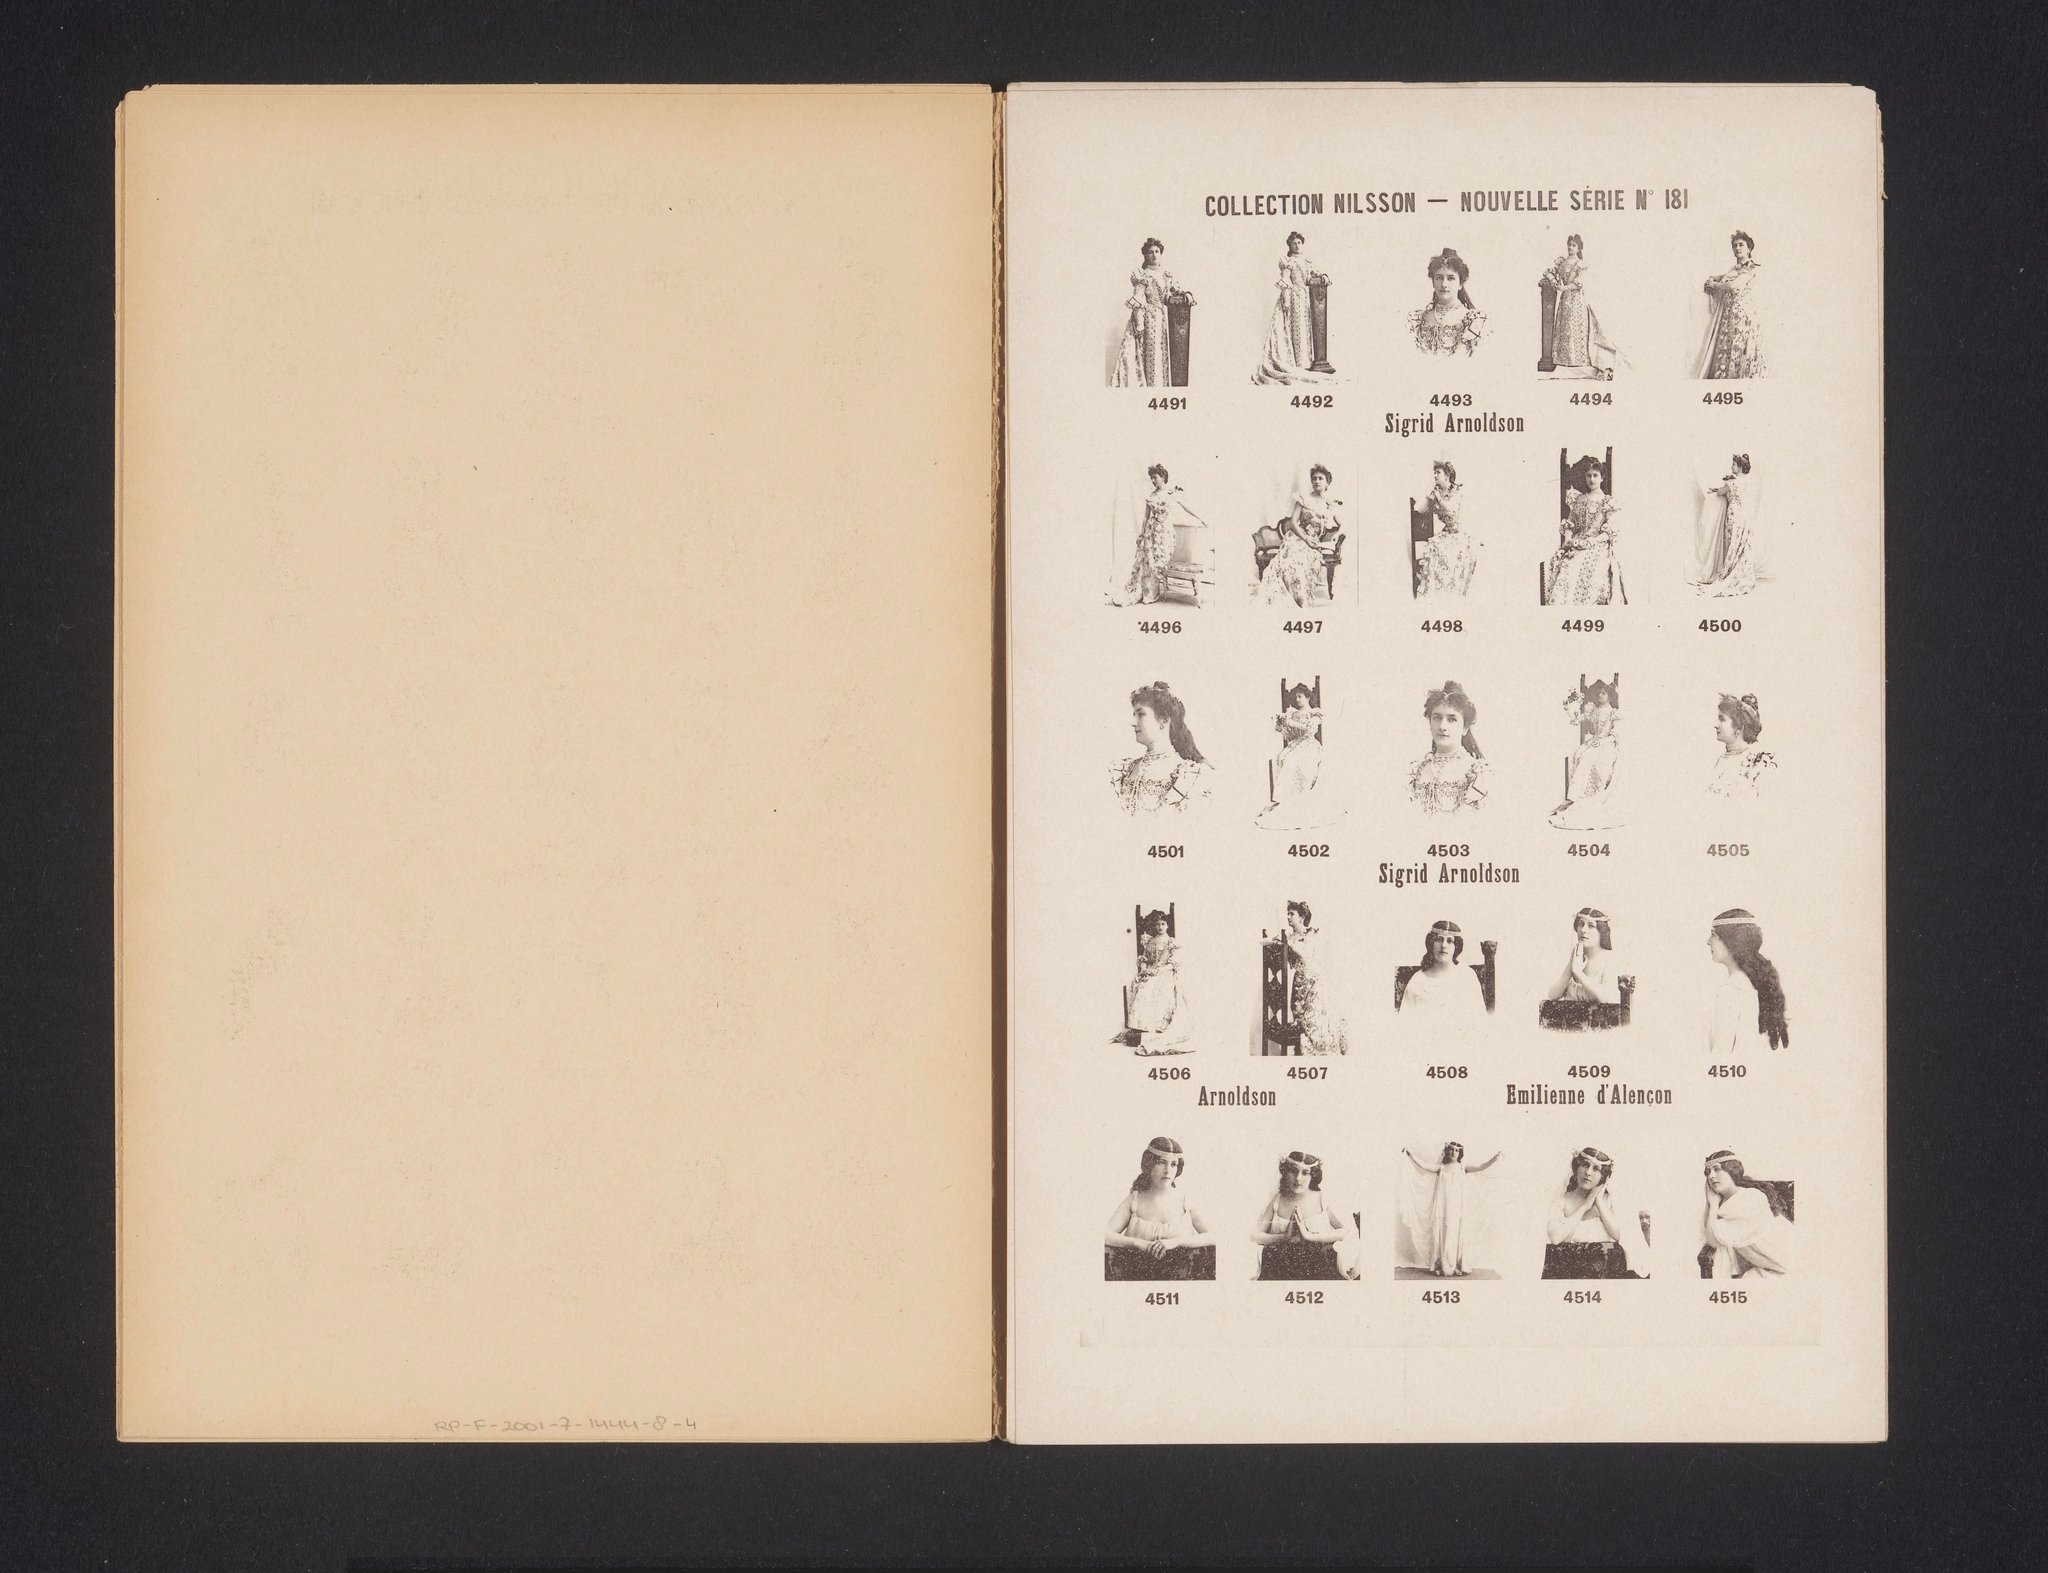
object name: photomechanical print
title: Collection Nilsson - Nouvelle Série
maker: Anonymous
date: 1894-1899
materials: paper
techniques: photograph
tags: paris, historical persons - bb - woman, portrait of actor, actress, portrait of dancer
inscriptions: number: ‘No 181’